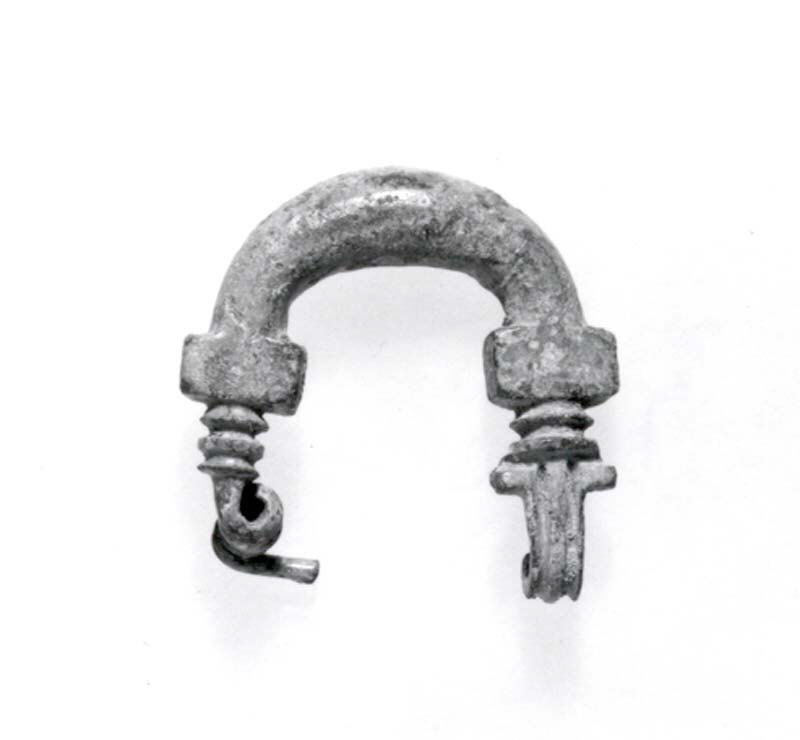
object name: fibula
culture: phrygian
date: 800-601 BCE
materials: bronze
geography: phrygia